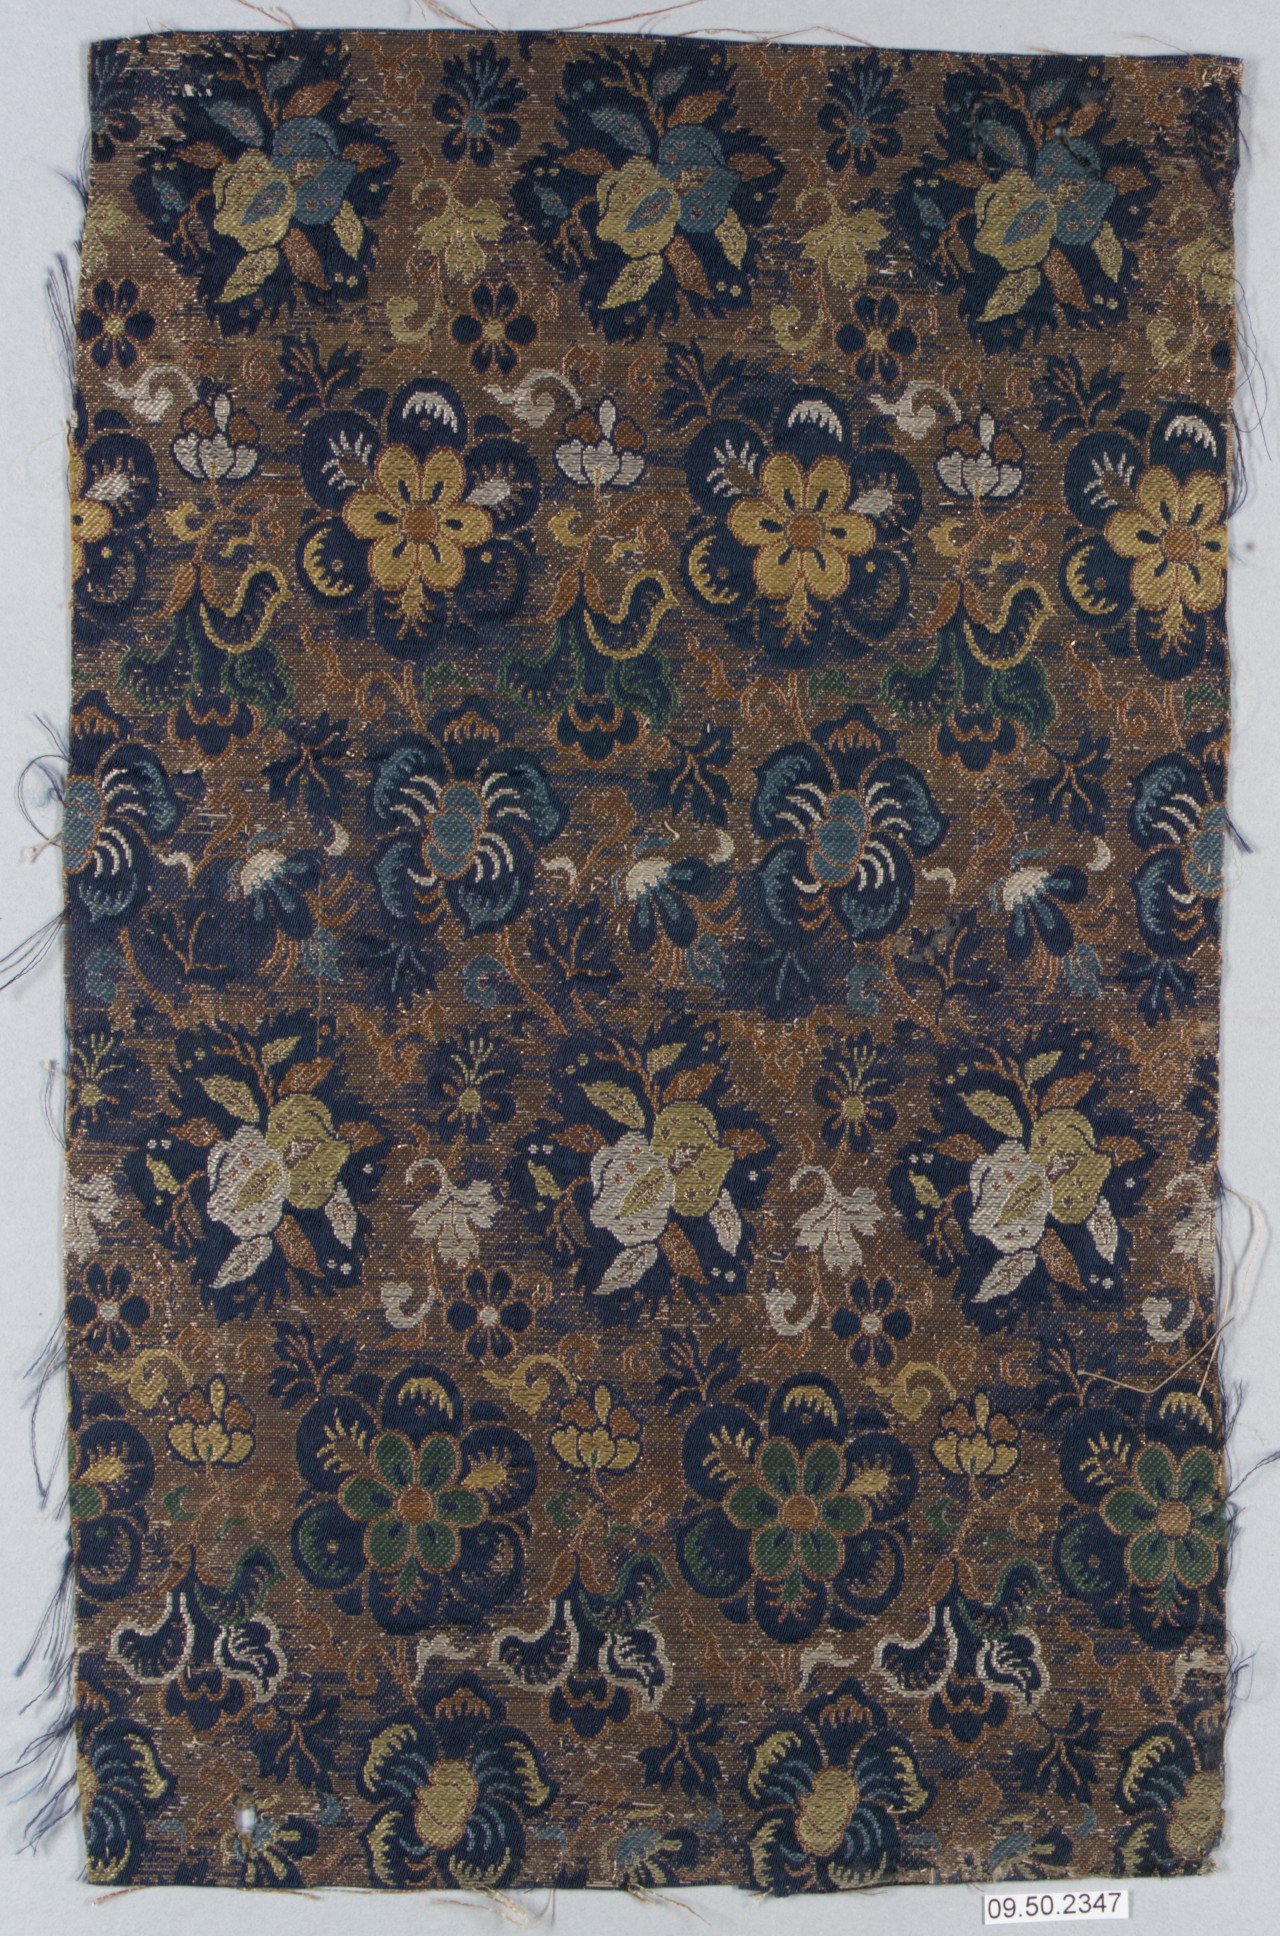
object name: fragment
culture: japanese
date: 1701-1800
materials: silk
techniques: brocade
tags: leaves